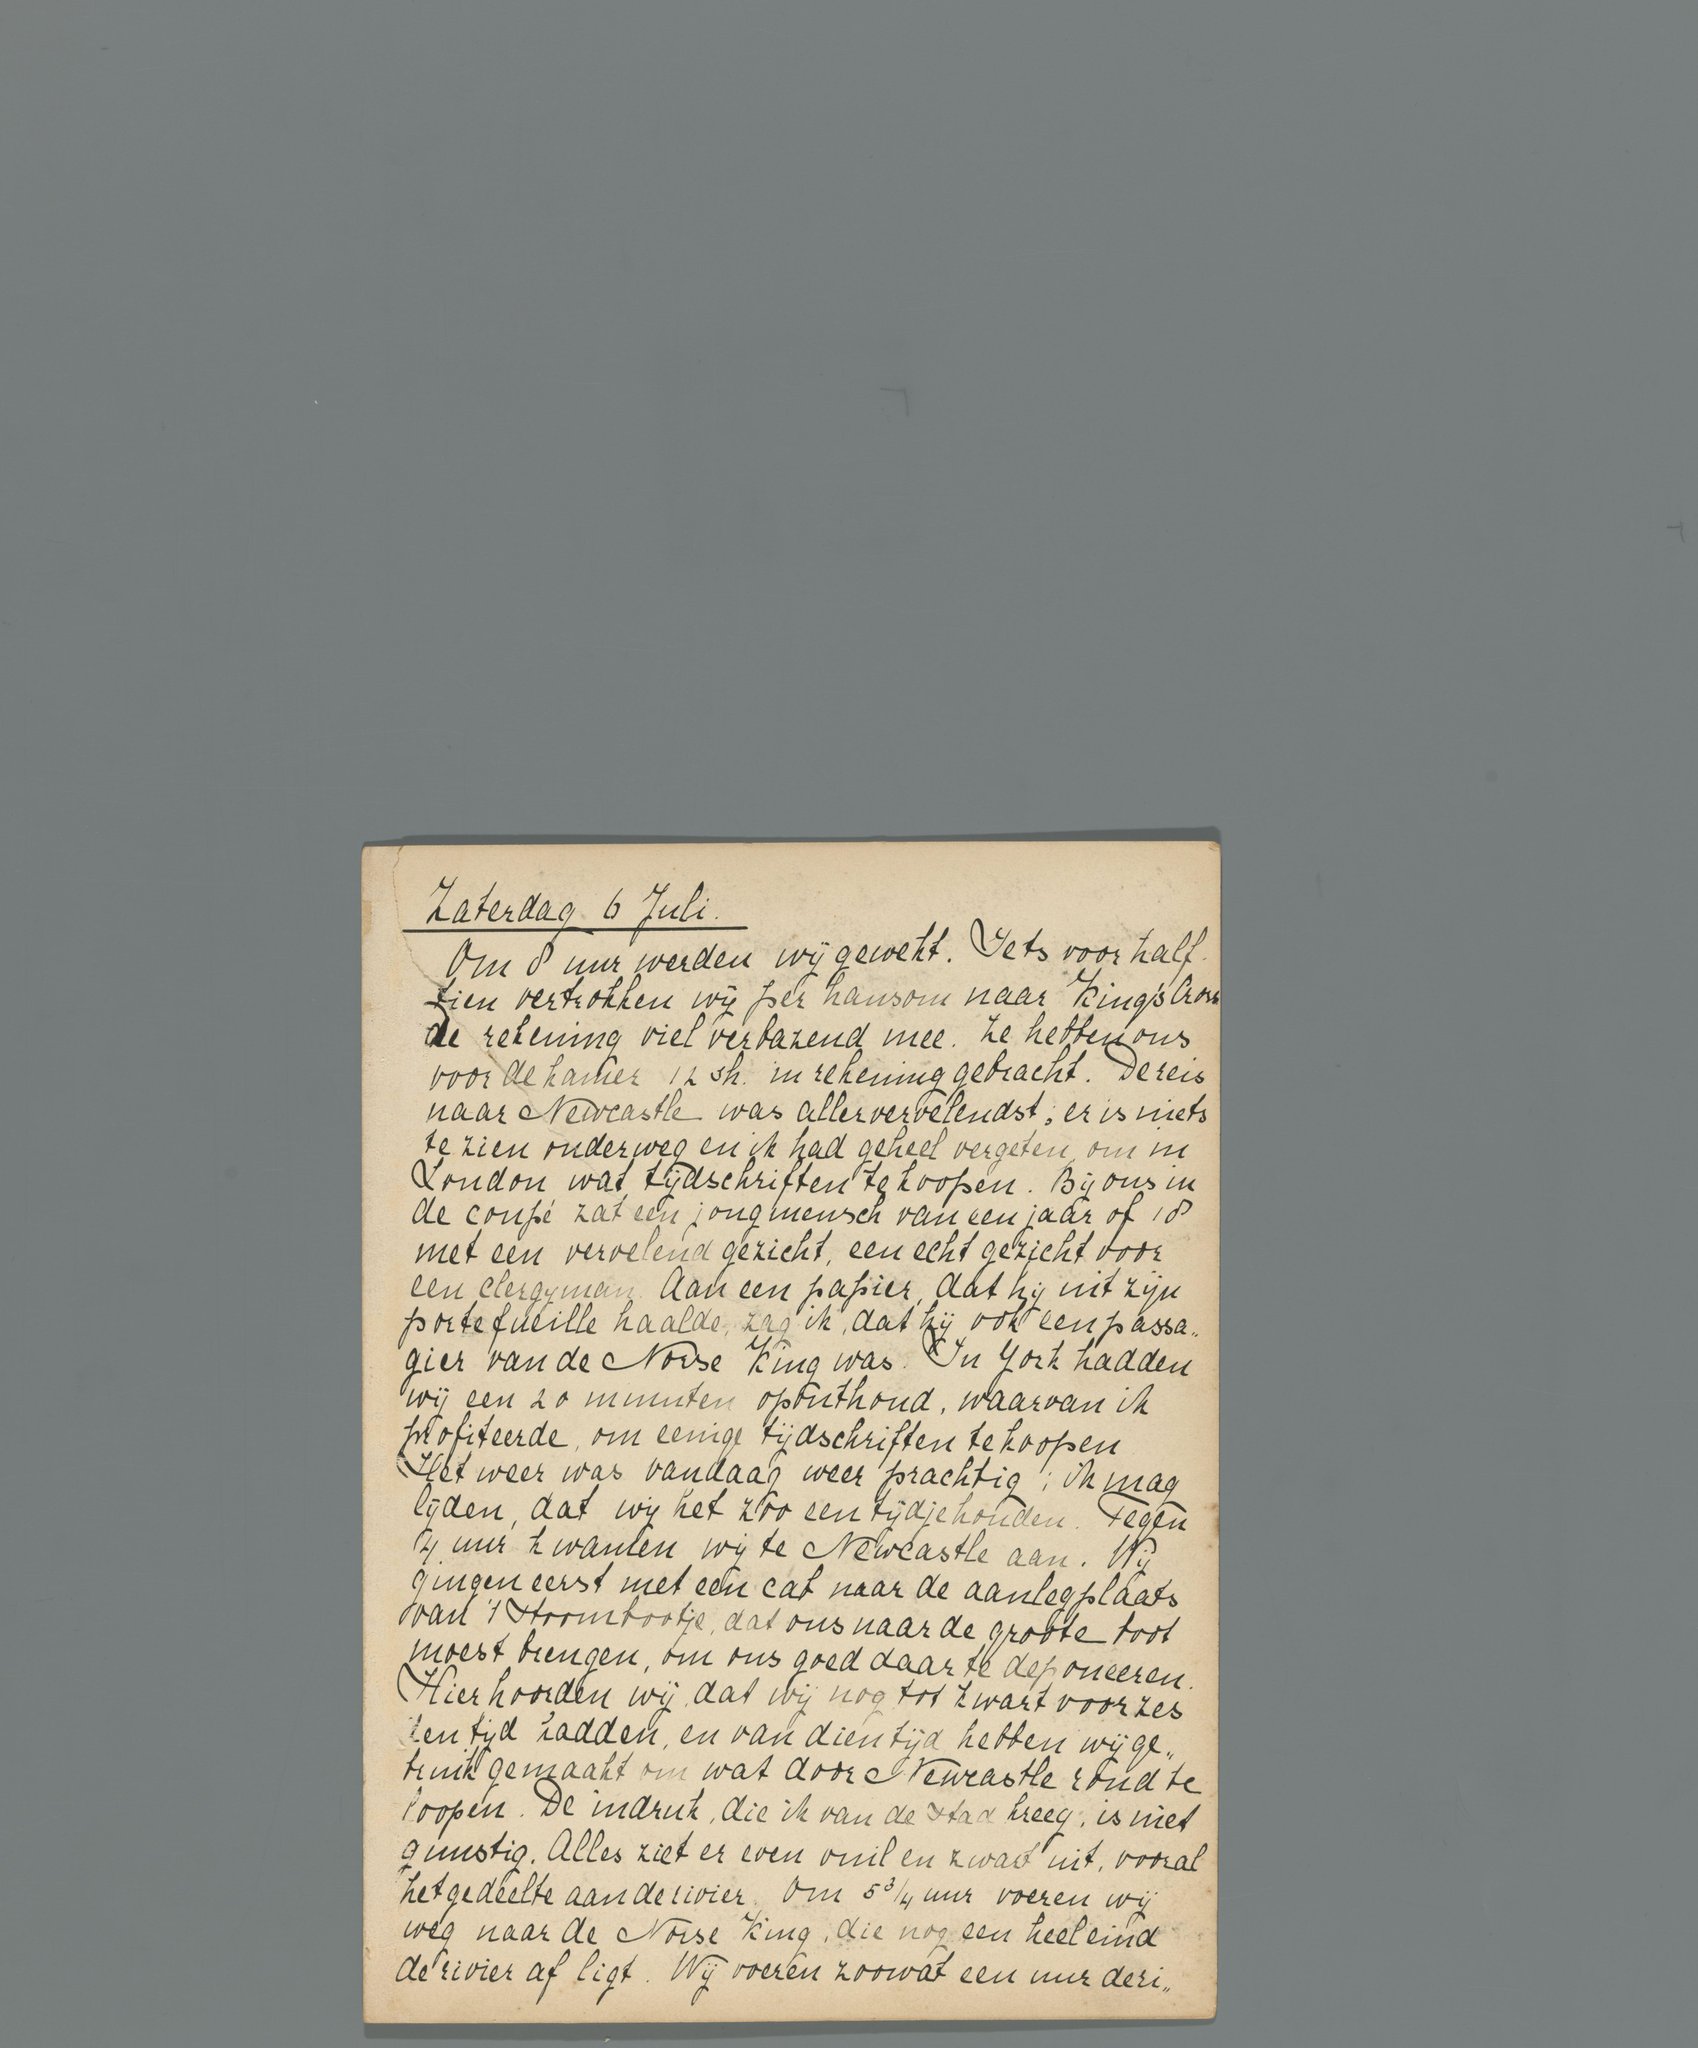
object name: diary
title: Derde pagina van een dagboek van een reis door Noorwegen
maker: hendrik herman van den berg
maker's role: amateurfotograaf, jurist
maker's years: 1875-1944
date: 1895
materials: ink, paper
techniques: pen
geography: norway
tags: batavia, amsterdam, hendrik herman van den berg, handwriting, written text, 'en route', traveller under way, norway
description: Derde pagina van een dagboek met het verslag van een reis door Noorwegen gemaakt door Hendrik Herman van den Berg en zijn neef Guillaume Louis Jacques Holle tussen 5 en 20 juli 1895.